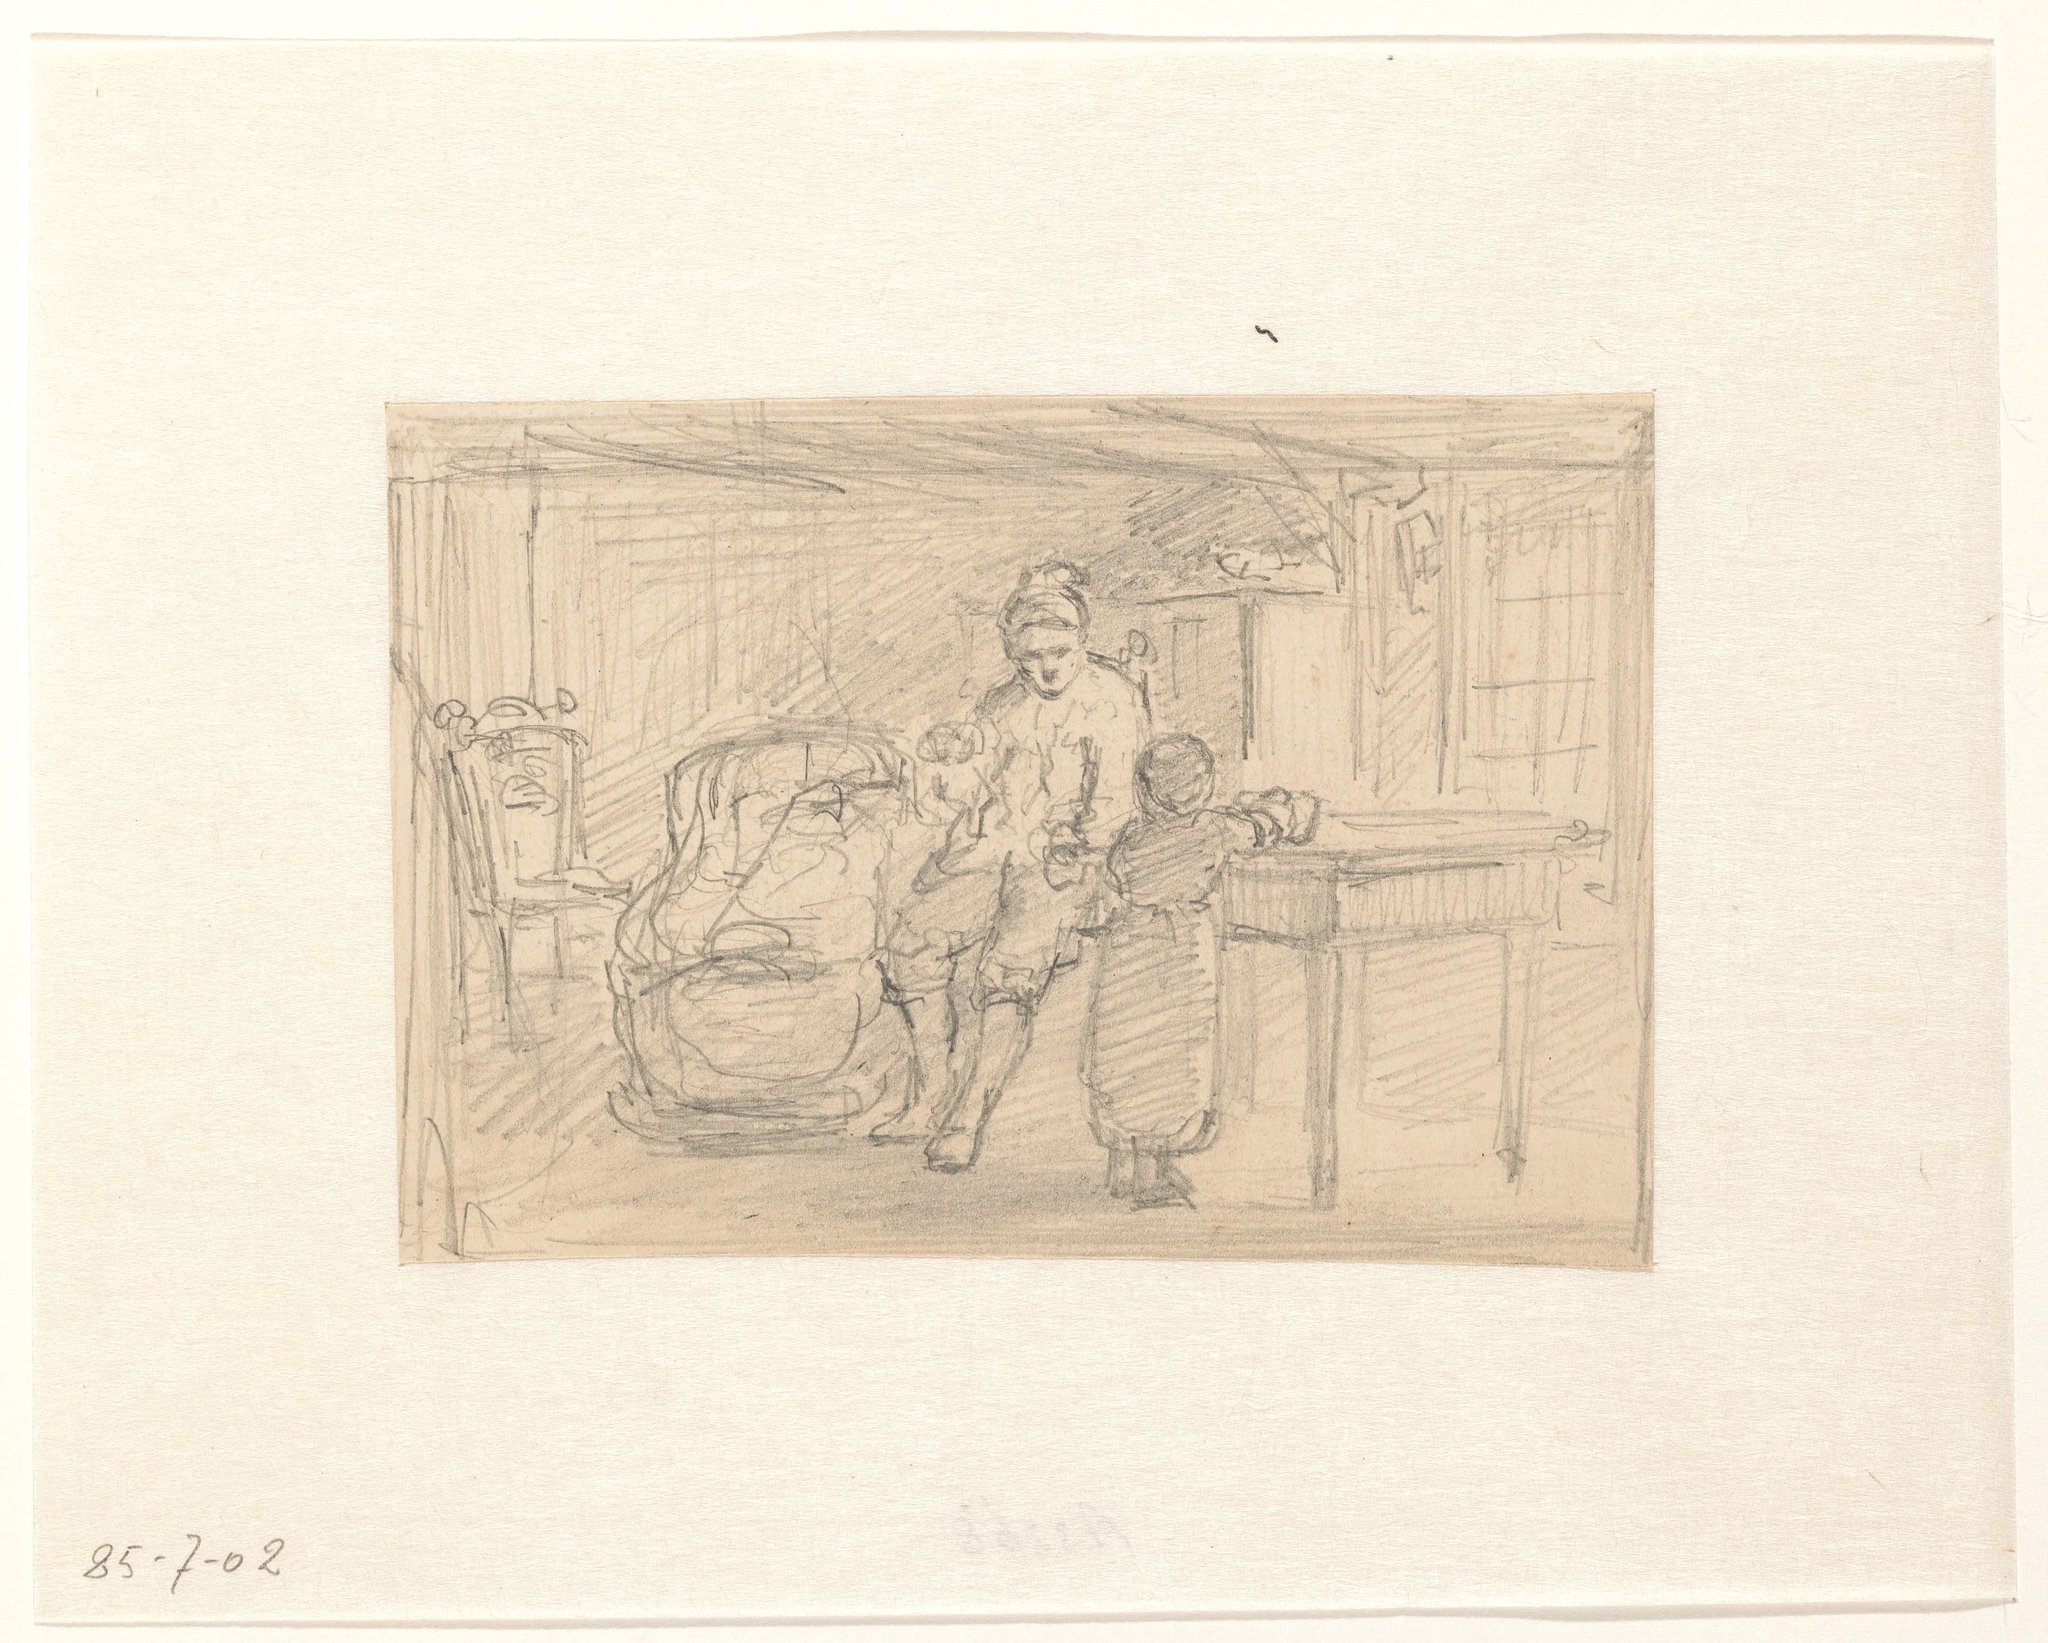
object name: drawing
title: Interieur met een man aan een tafel, een wieg en een meisje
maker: hendrik valkenburg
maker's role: draughtsman, painter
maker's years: 1826-1896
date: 1836-1896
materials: paper, pencil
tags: interior of the house, father and child(ren), man and child(ren) (family group)